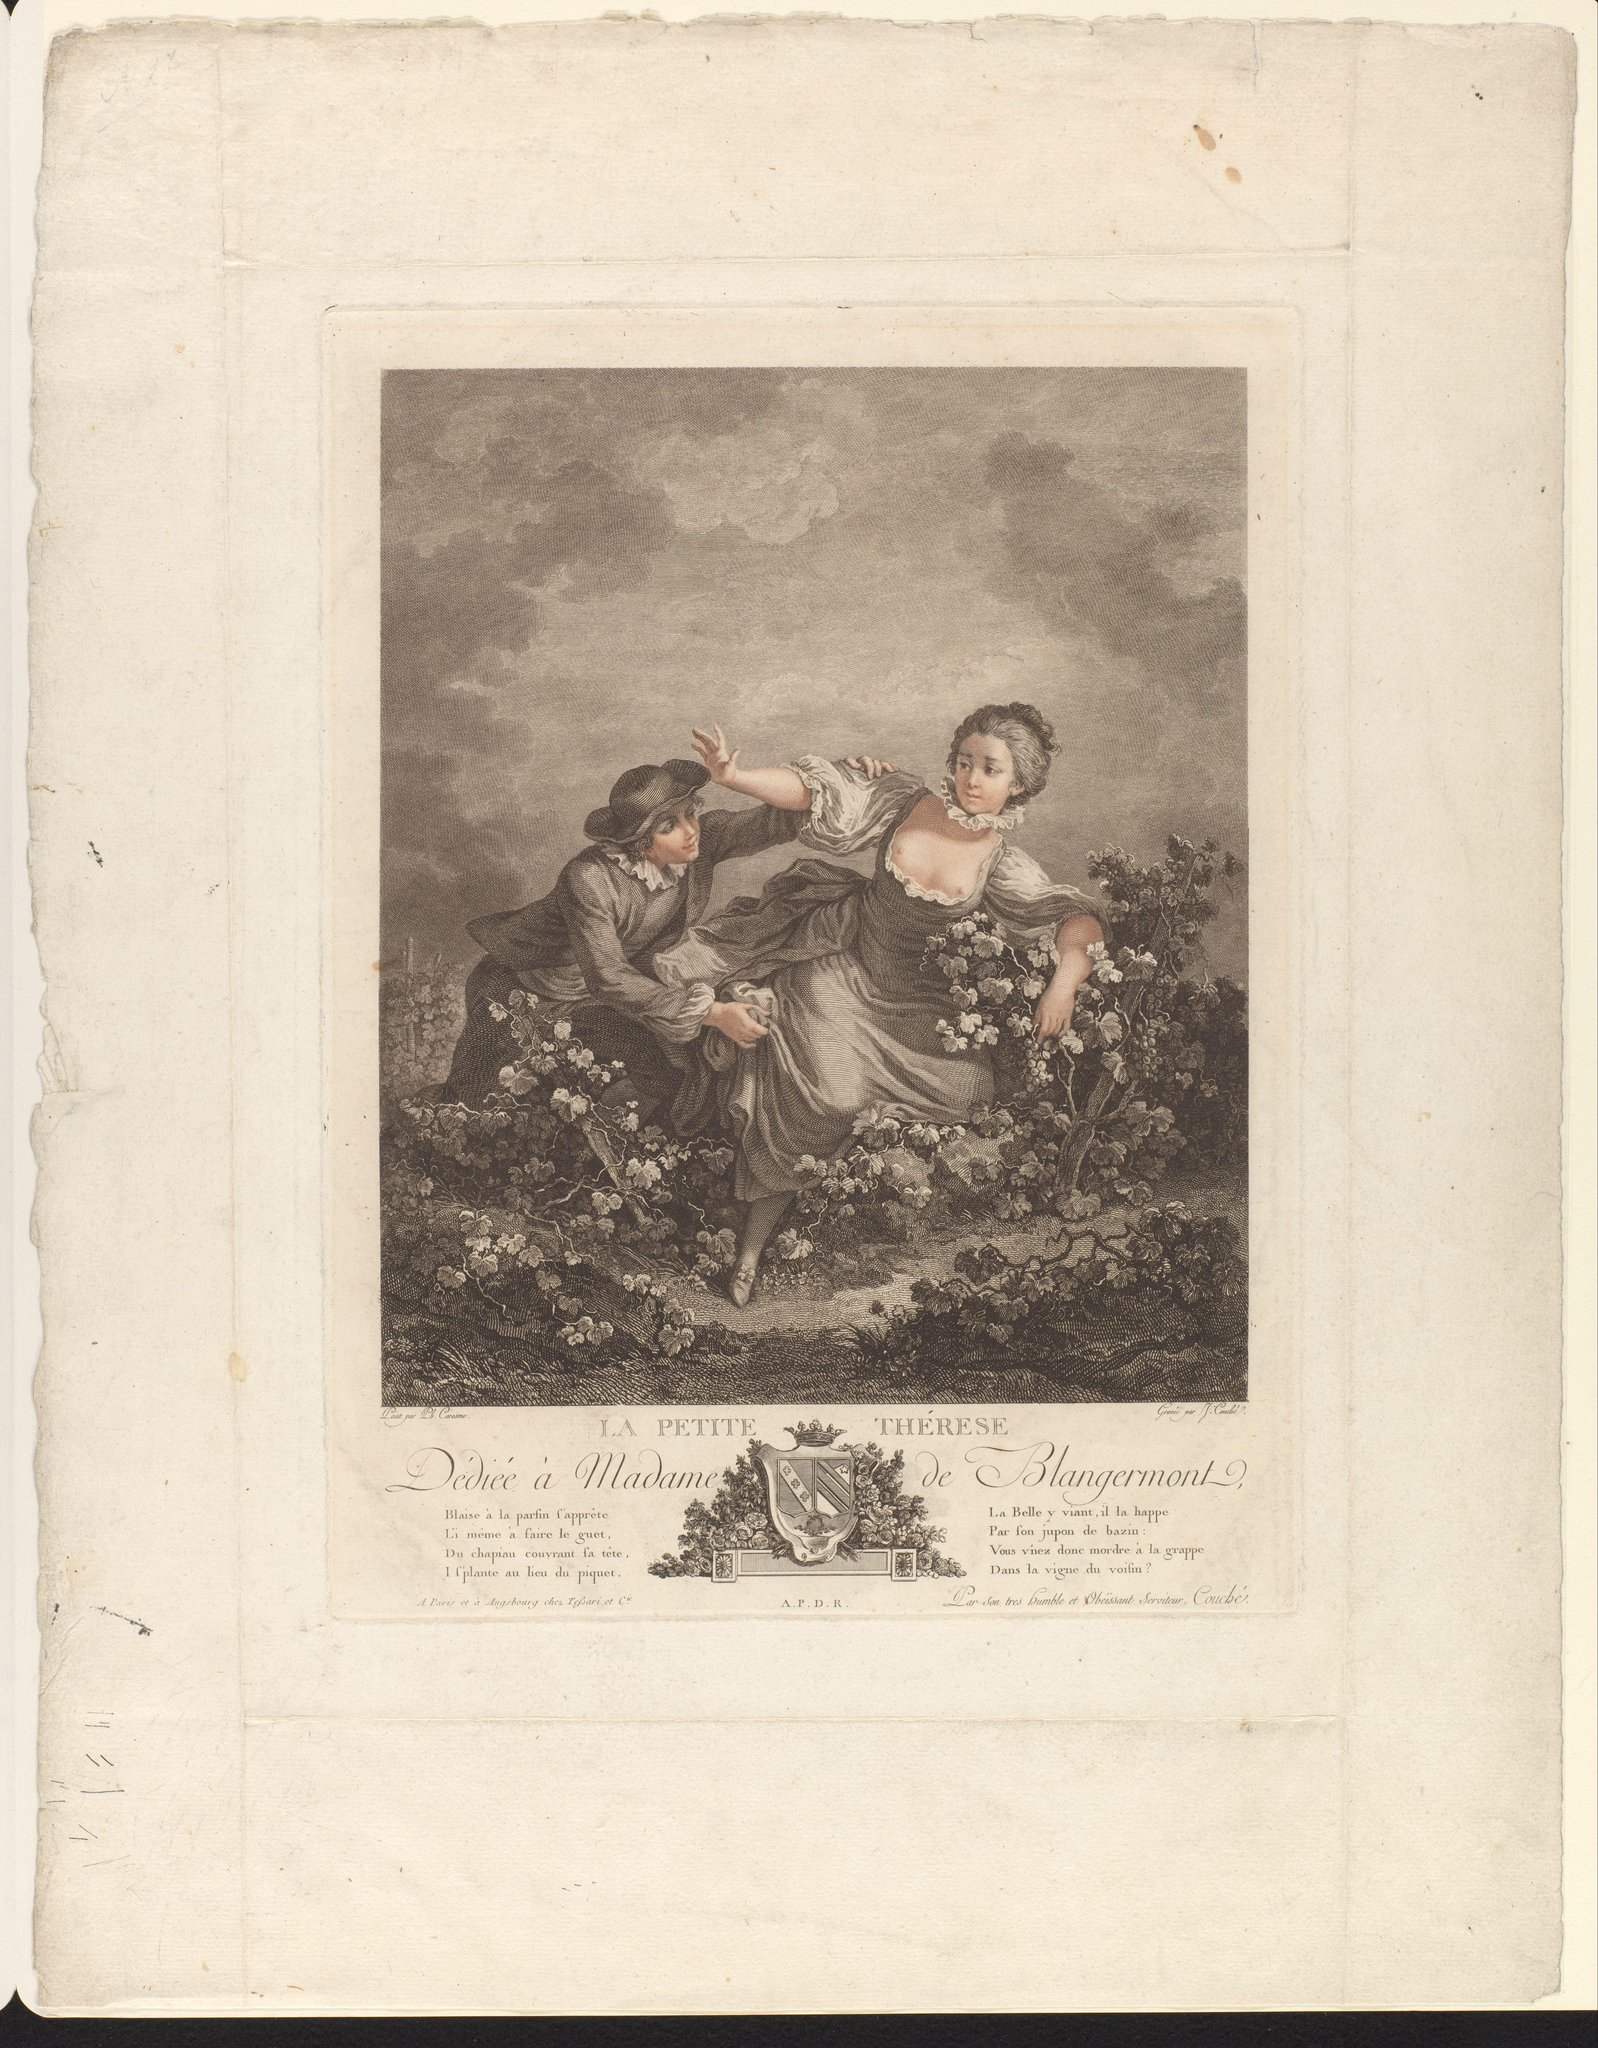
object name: print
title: La Petite Thérèse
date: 1760-1836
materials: paper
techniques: engraving, lithography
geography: augsburg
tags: breasts, adolescent, young woman, maiden, catch (~ running game), courting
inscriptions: collector's mark: Lugt 2228